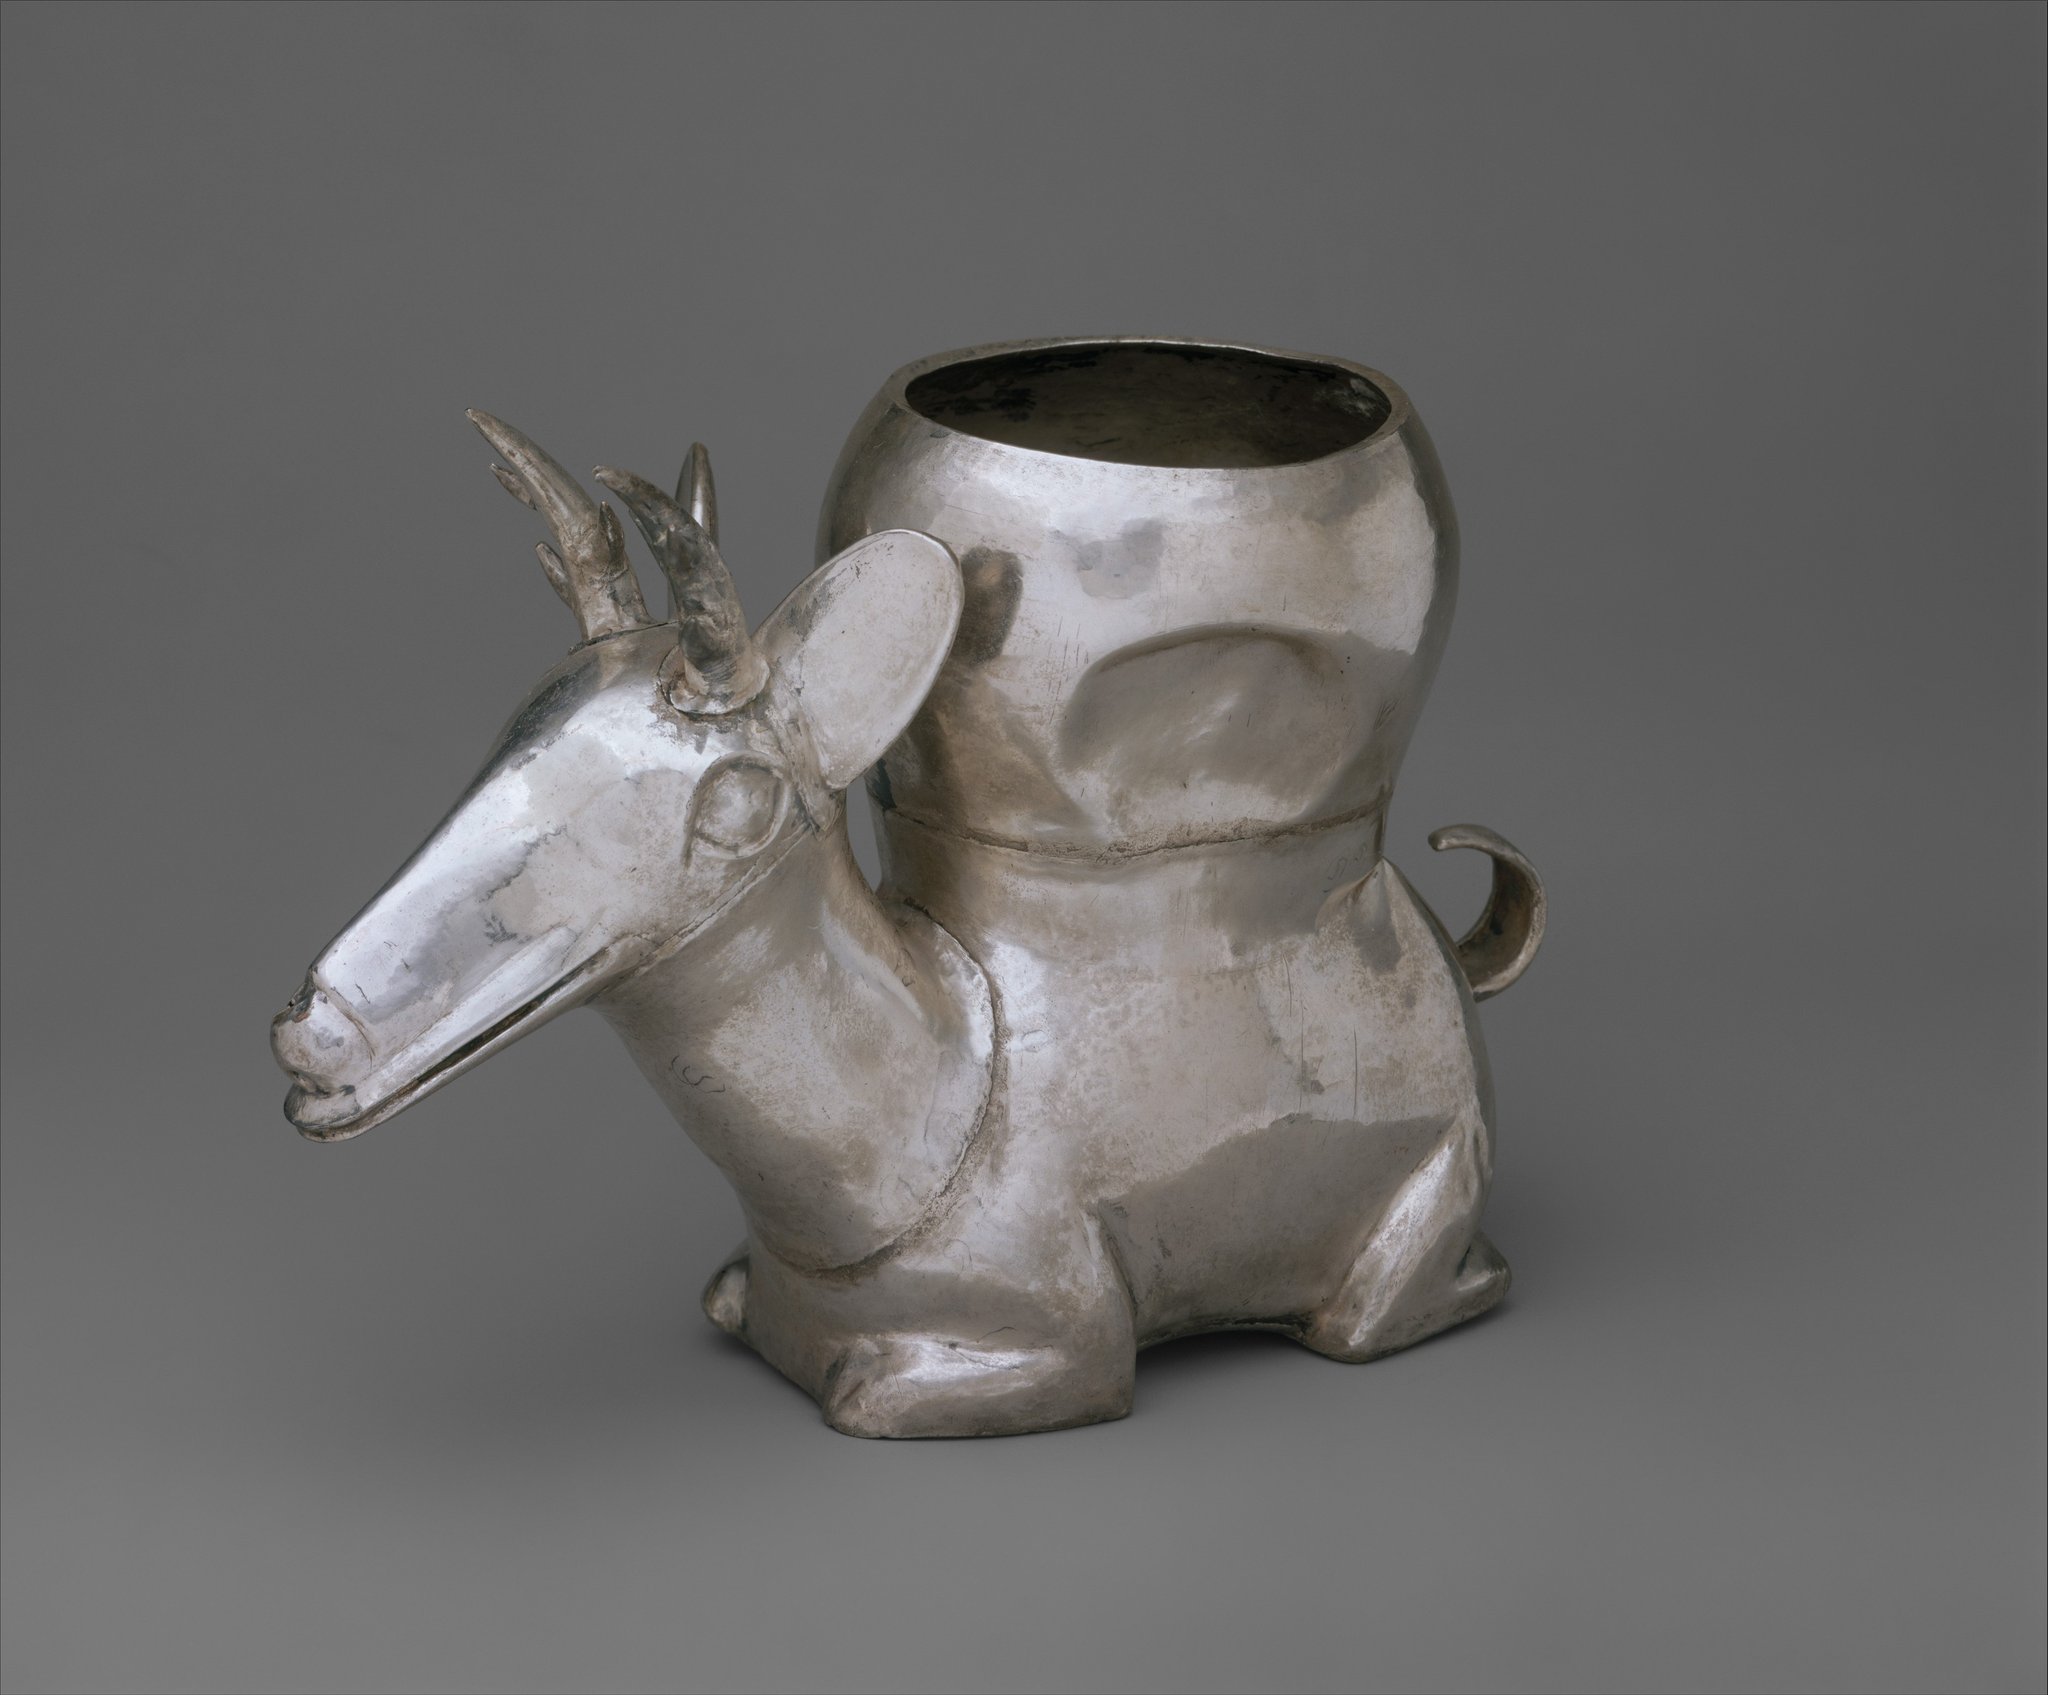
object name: vessel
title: Deer-shaped vessel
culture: chimú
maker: chimú artist(s)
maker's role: artist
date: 1350-1470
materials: silver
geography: peru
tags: deer